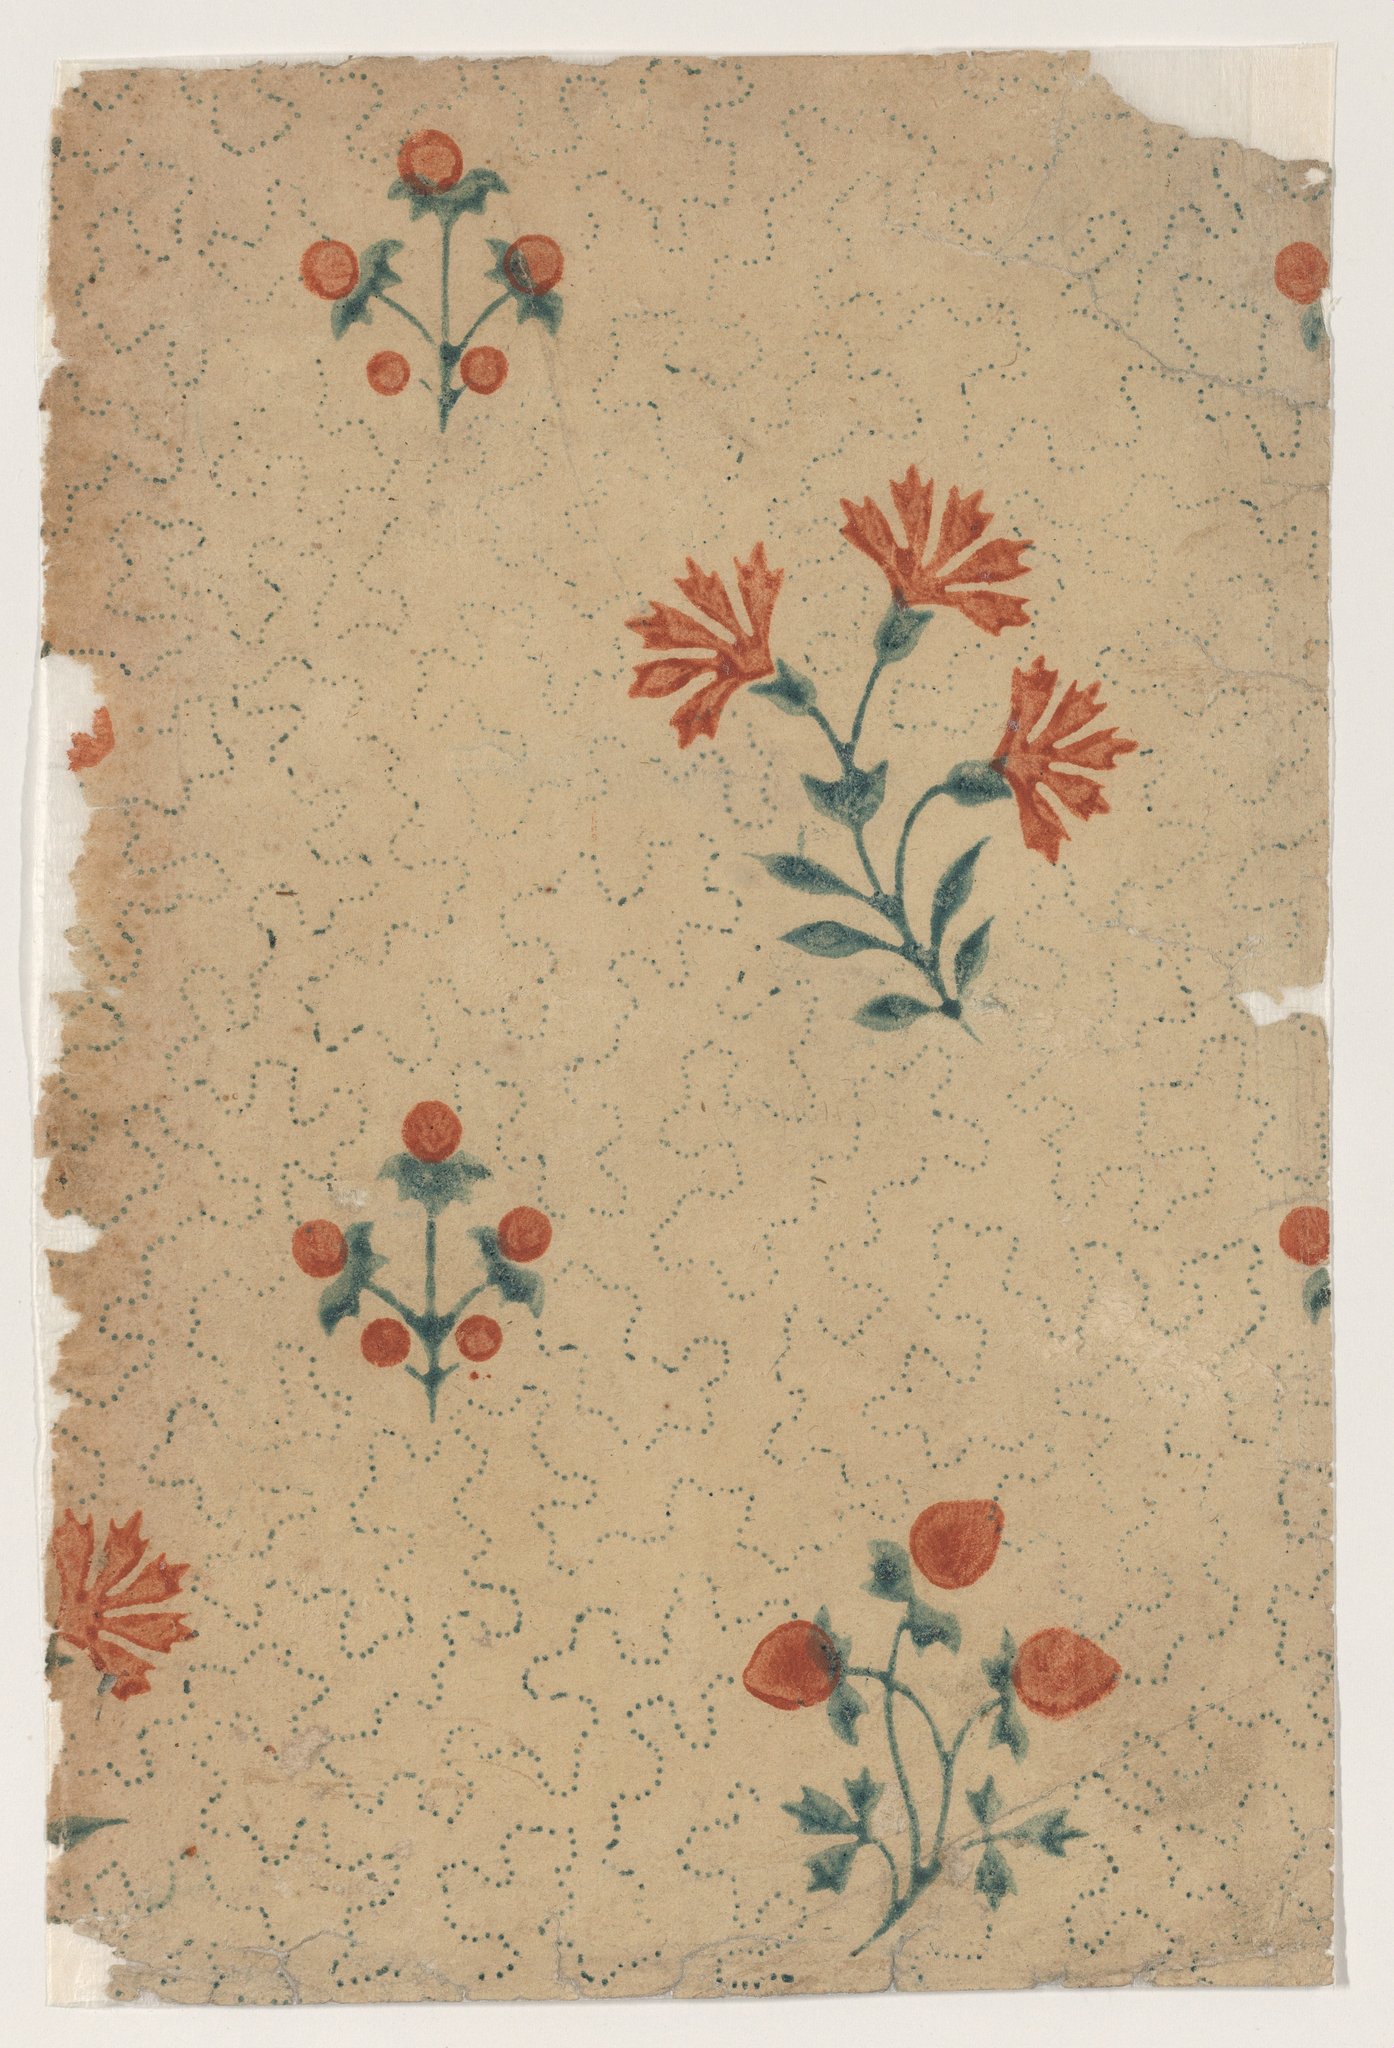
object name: print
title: Sheet with overall dot pattern with bouquets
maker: Anonymous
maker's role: artist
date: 1801-1900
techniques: relief print